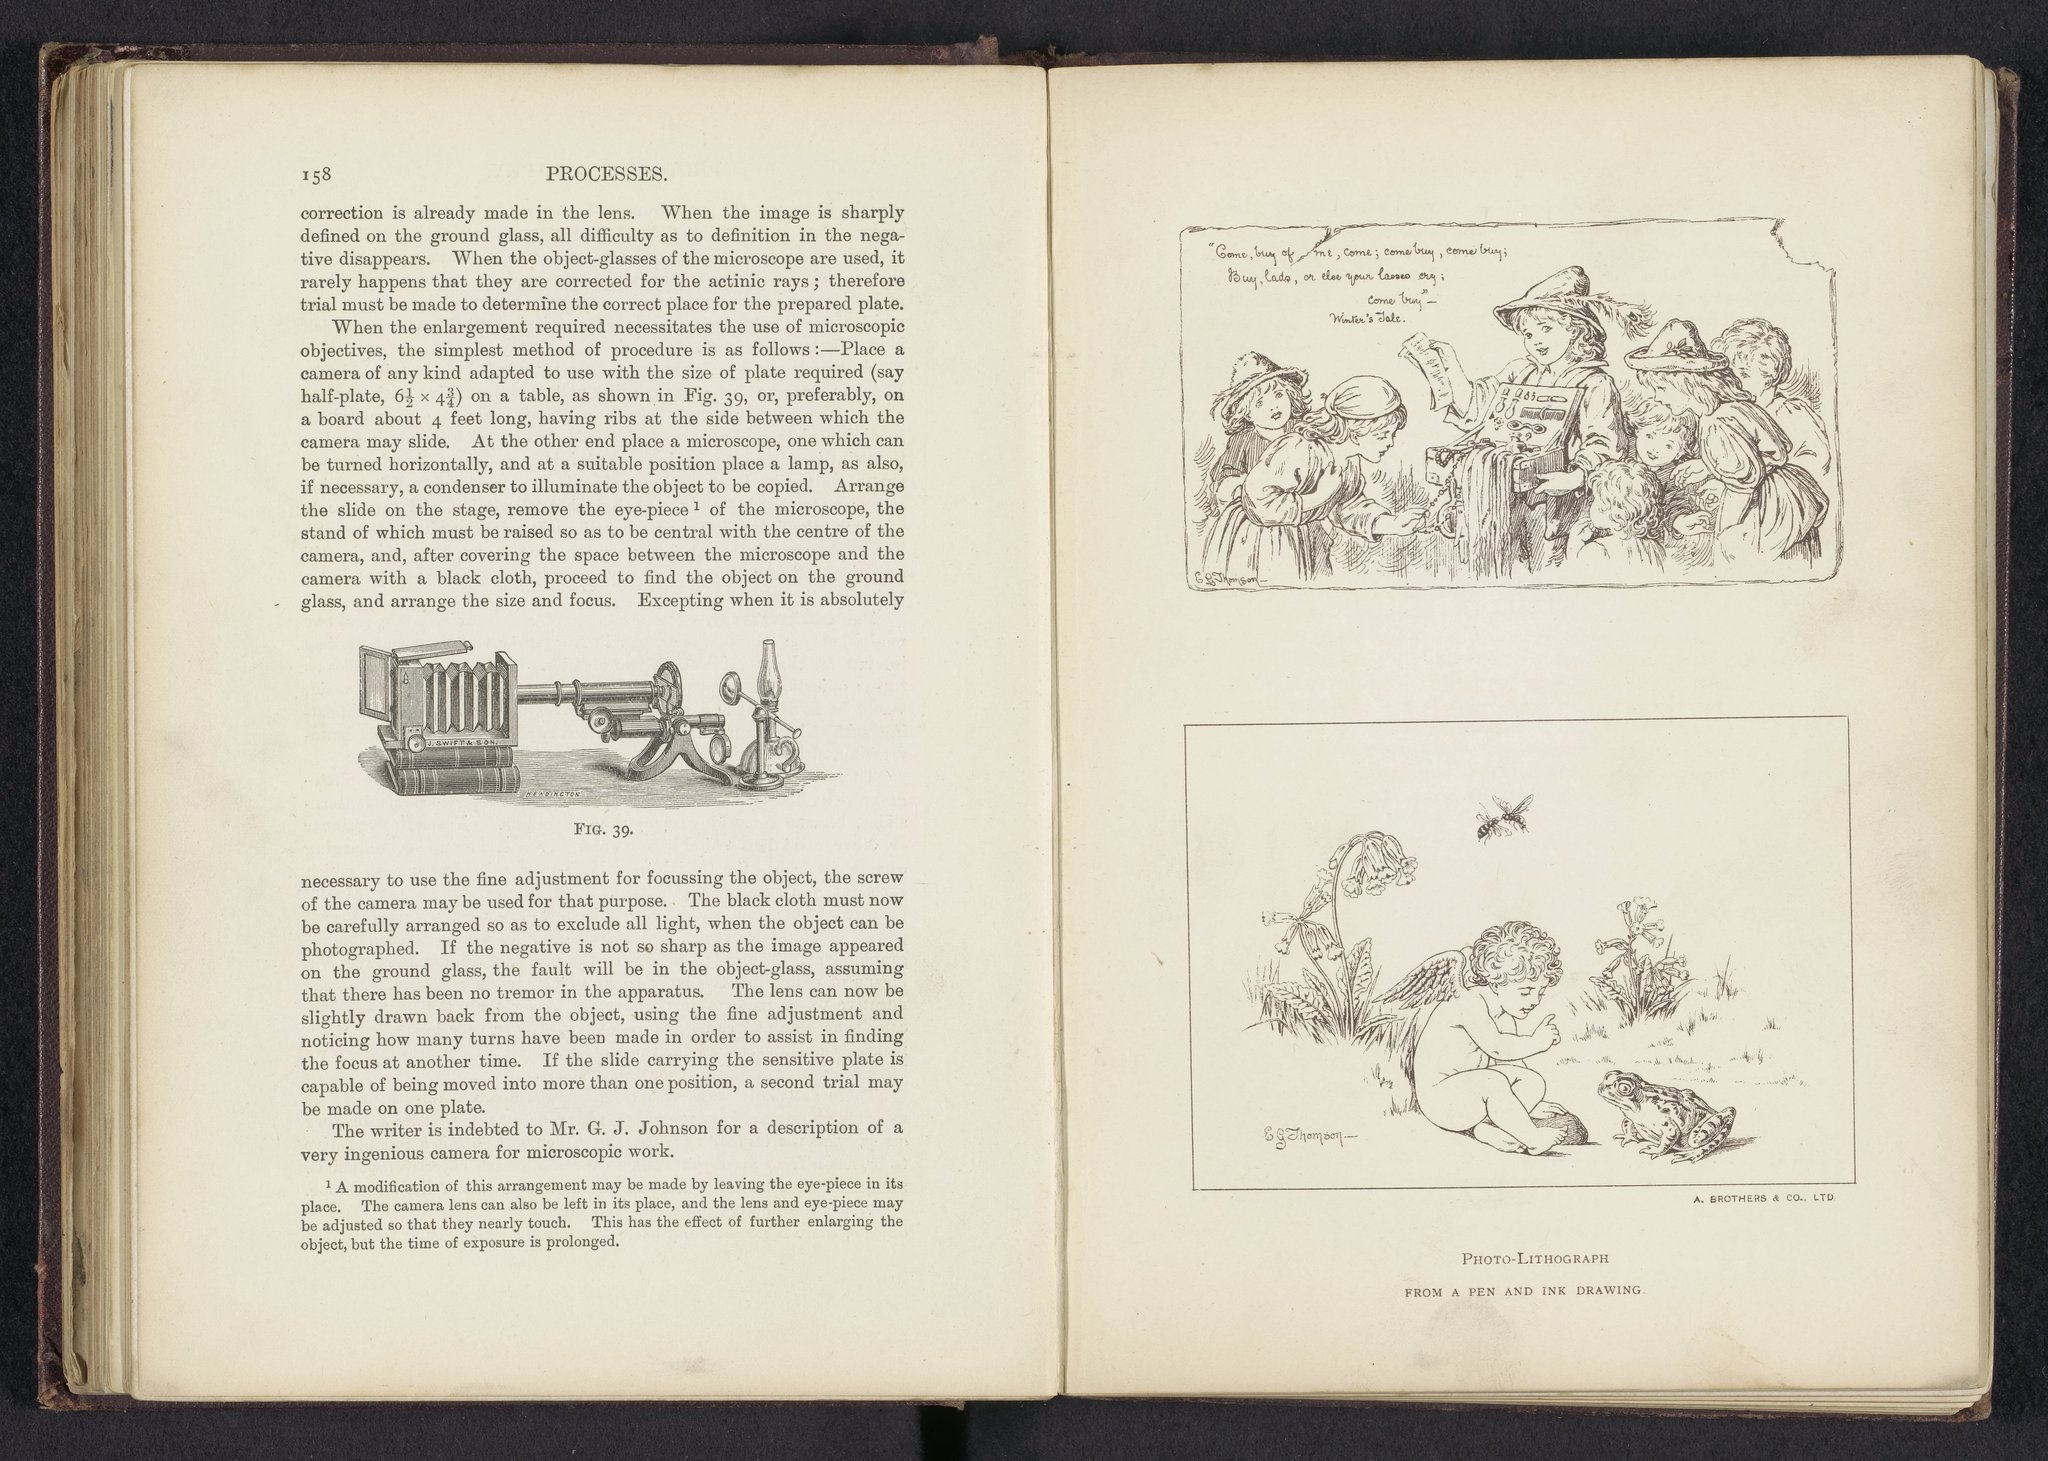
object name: page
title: Twee fotoreproducties van tekeningen, voorstellende een straatverkoper en een putto met een kikker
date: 1889-1899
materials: paper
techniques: photolithography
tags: tailless amphibians: frog, cupids: 'amores', 'amoretti', 'putti', merchant, salesman